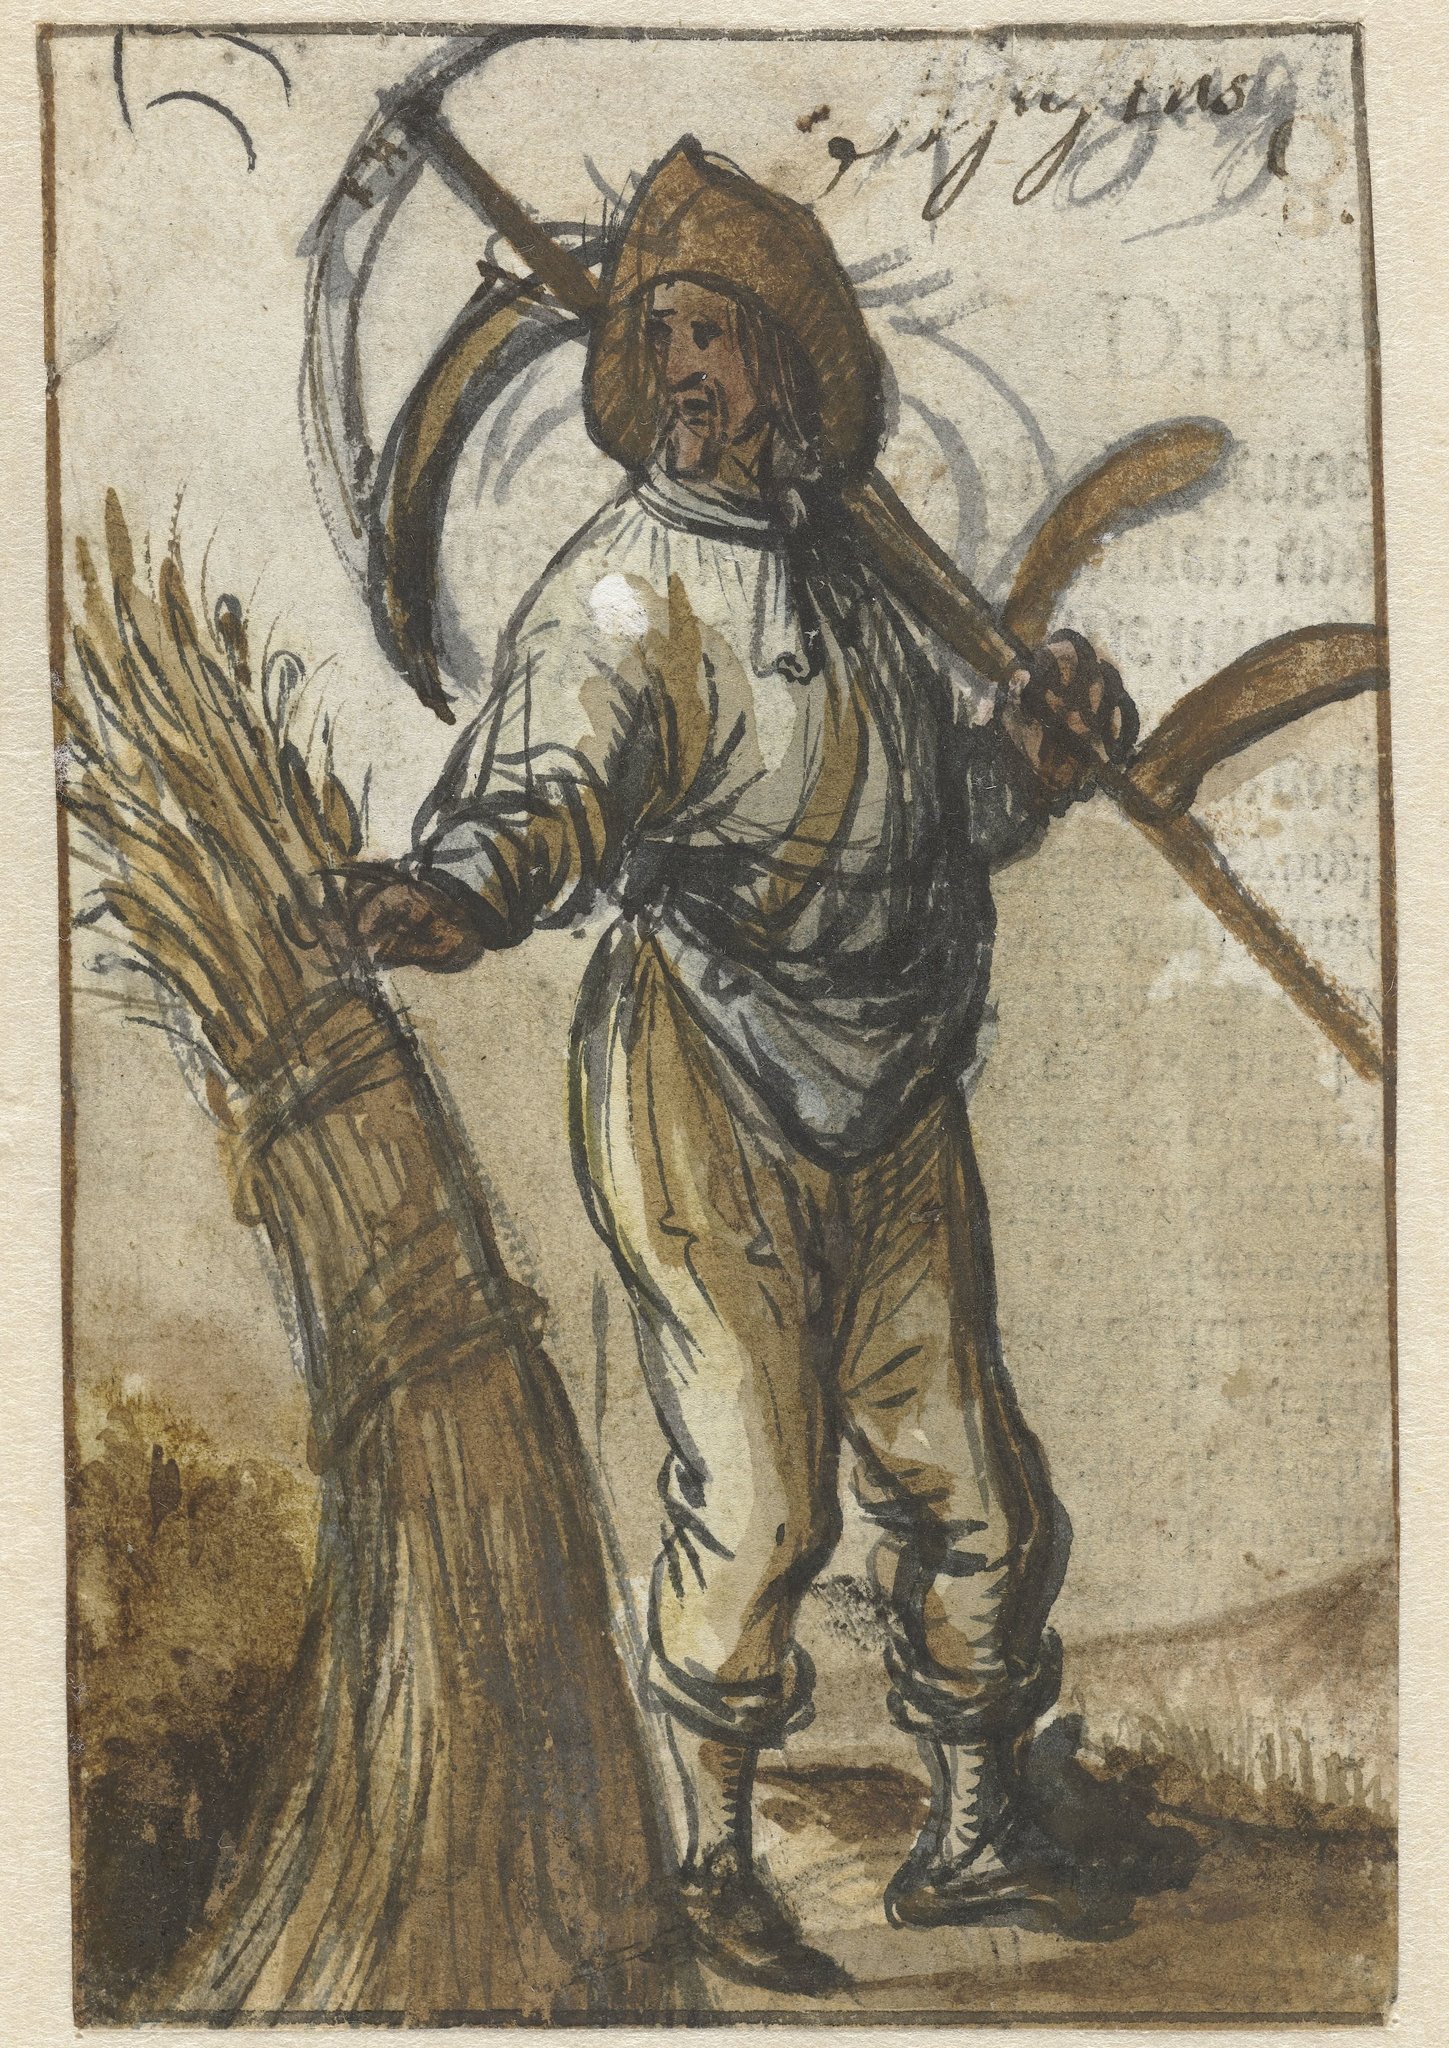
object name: drawing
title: De twaalf maanden van het jaar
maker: Anonymous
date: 1600-1699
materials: paper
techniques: brush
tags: agricultural implements: scythe, august and its 'labours', farmers, sheaf